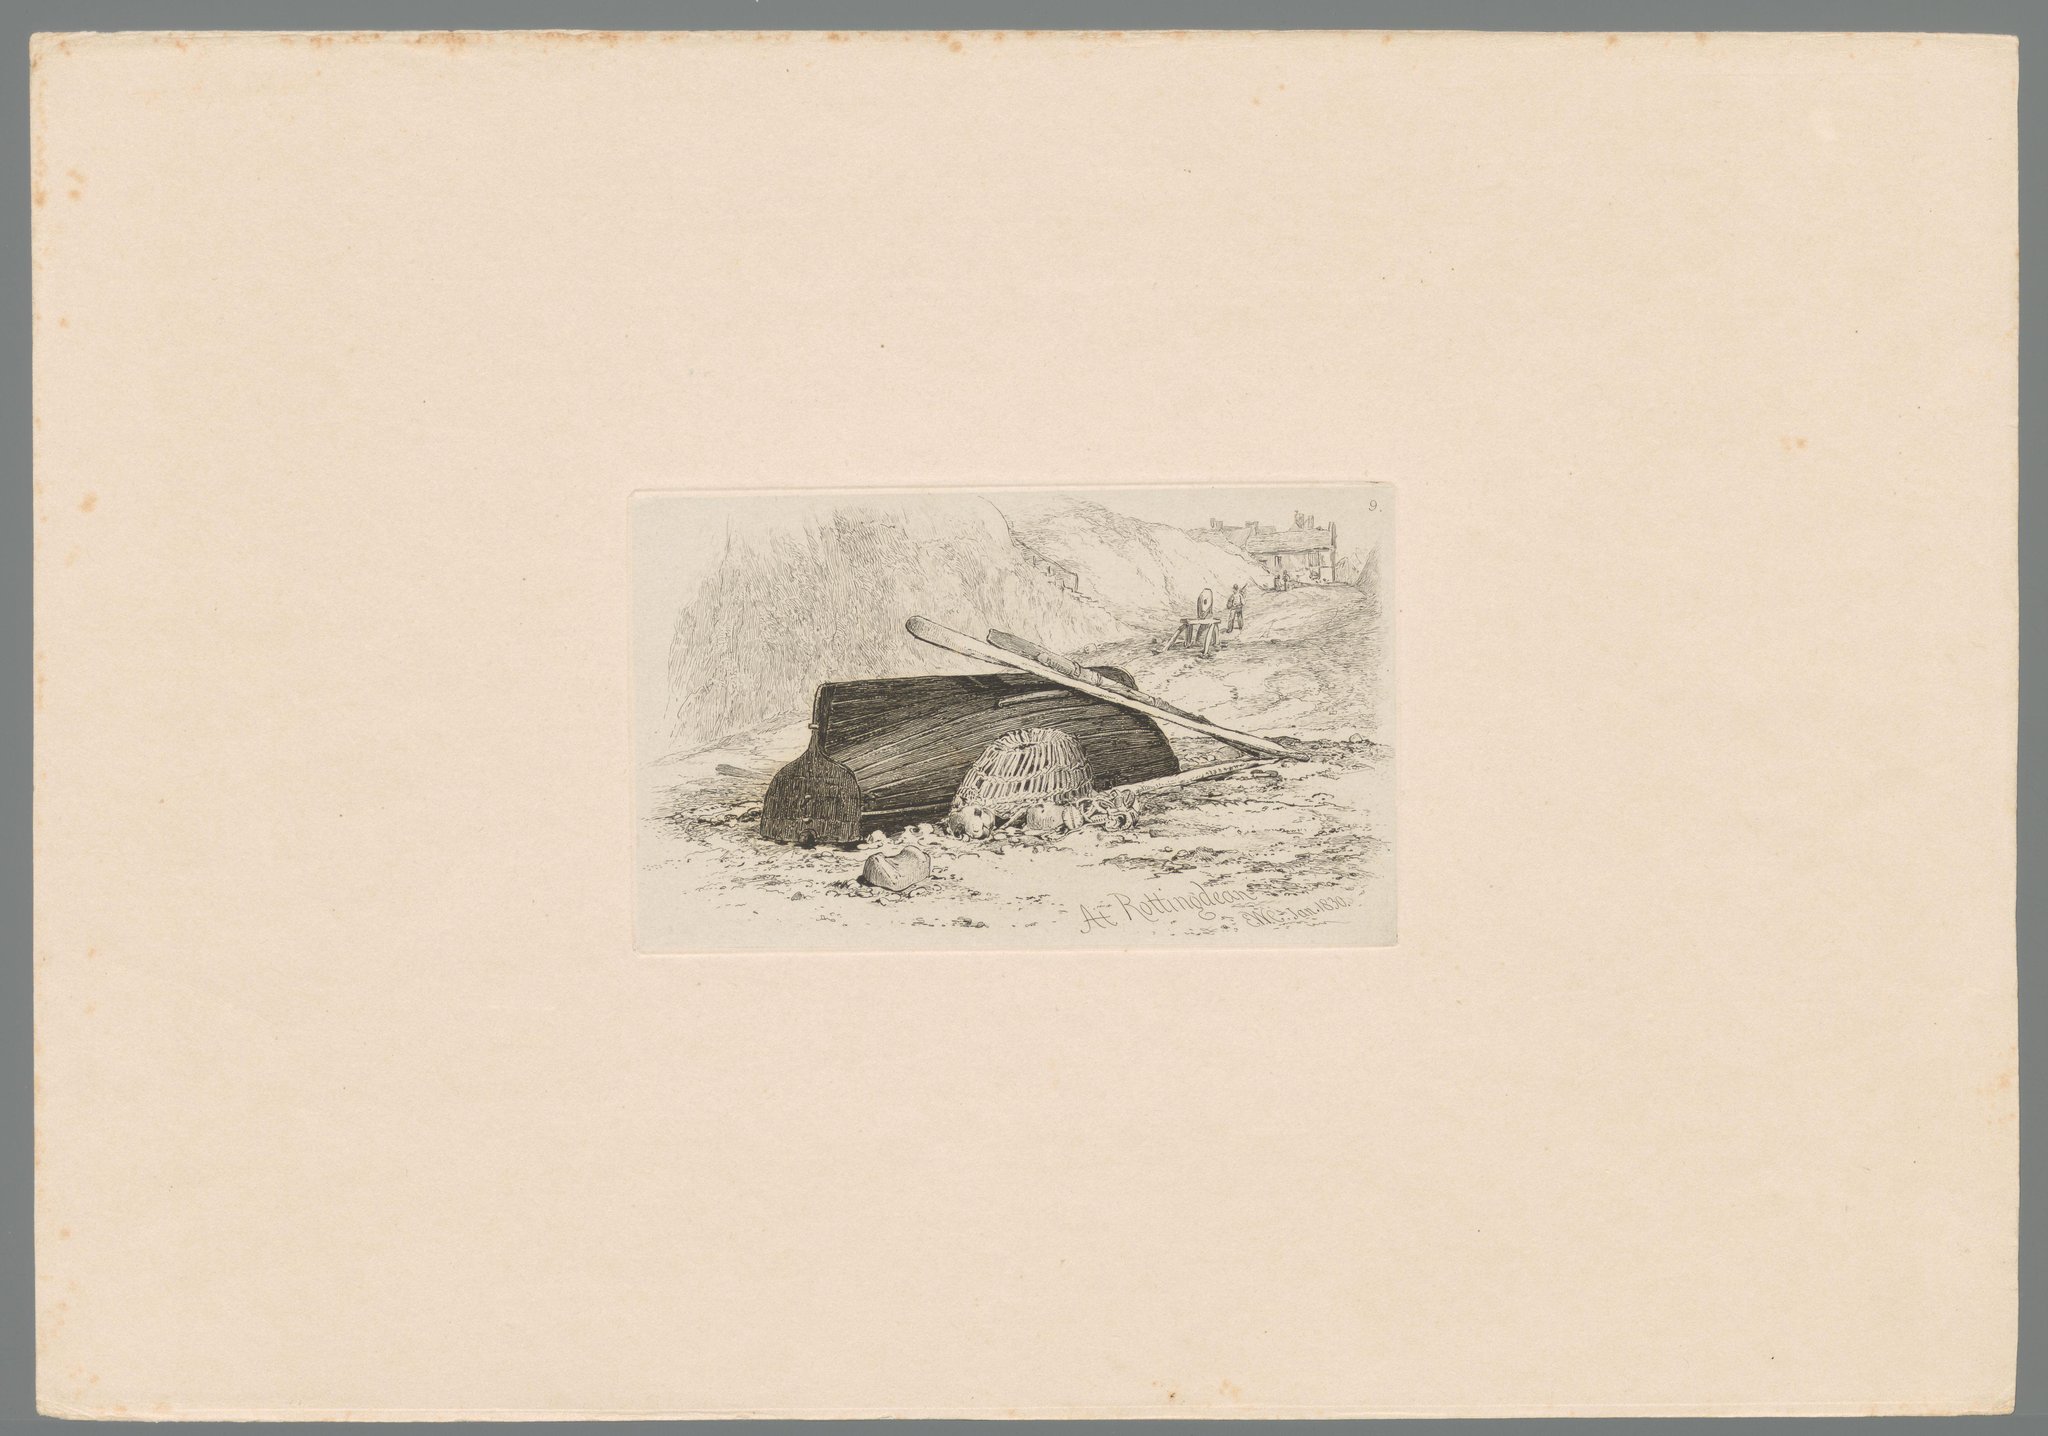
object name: print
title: Coastal scenery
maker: edward william cooke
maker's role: print maker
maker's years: 1811-1880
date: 1801-1830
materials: paper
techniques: etching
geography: england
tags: housing, rowing-boat, canoe, etc., road, path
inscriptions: collector's mark: Lugt 2165